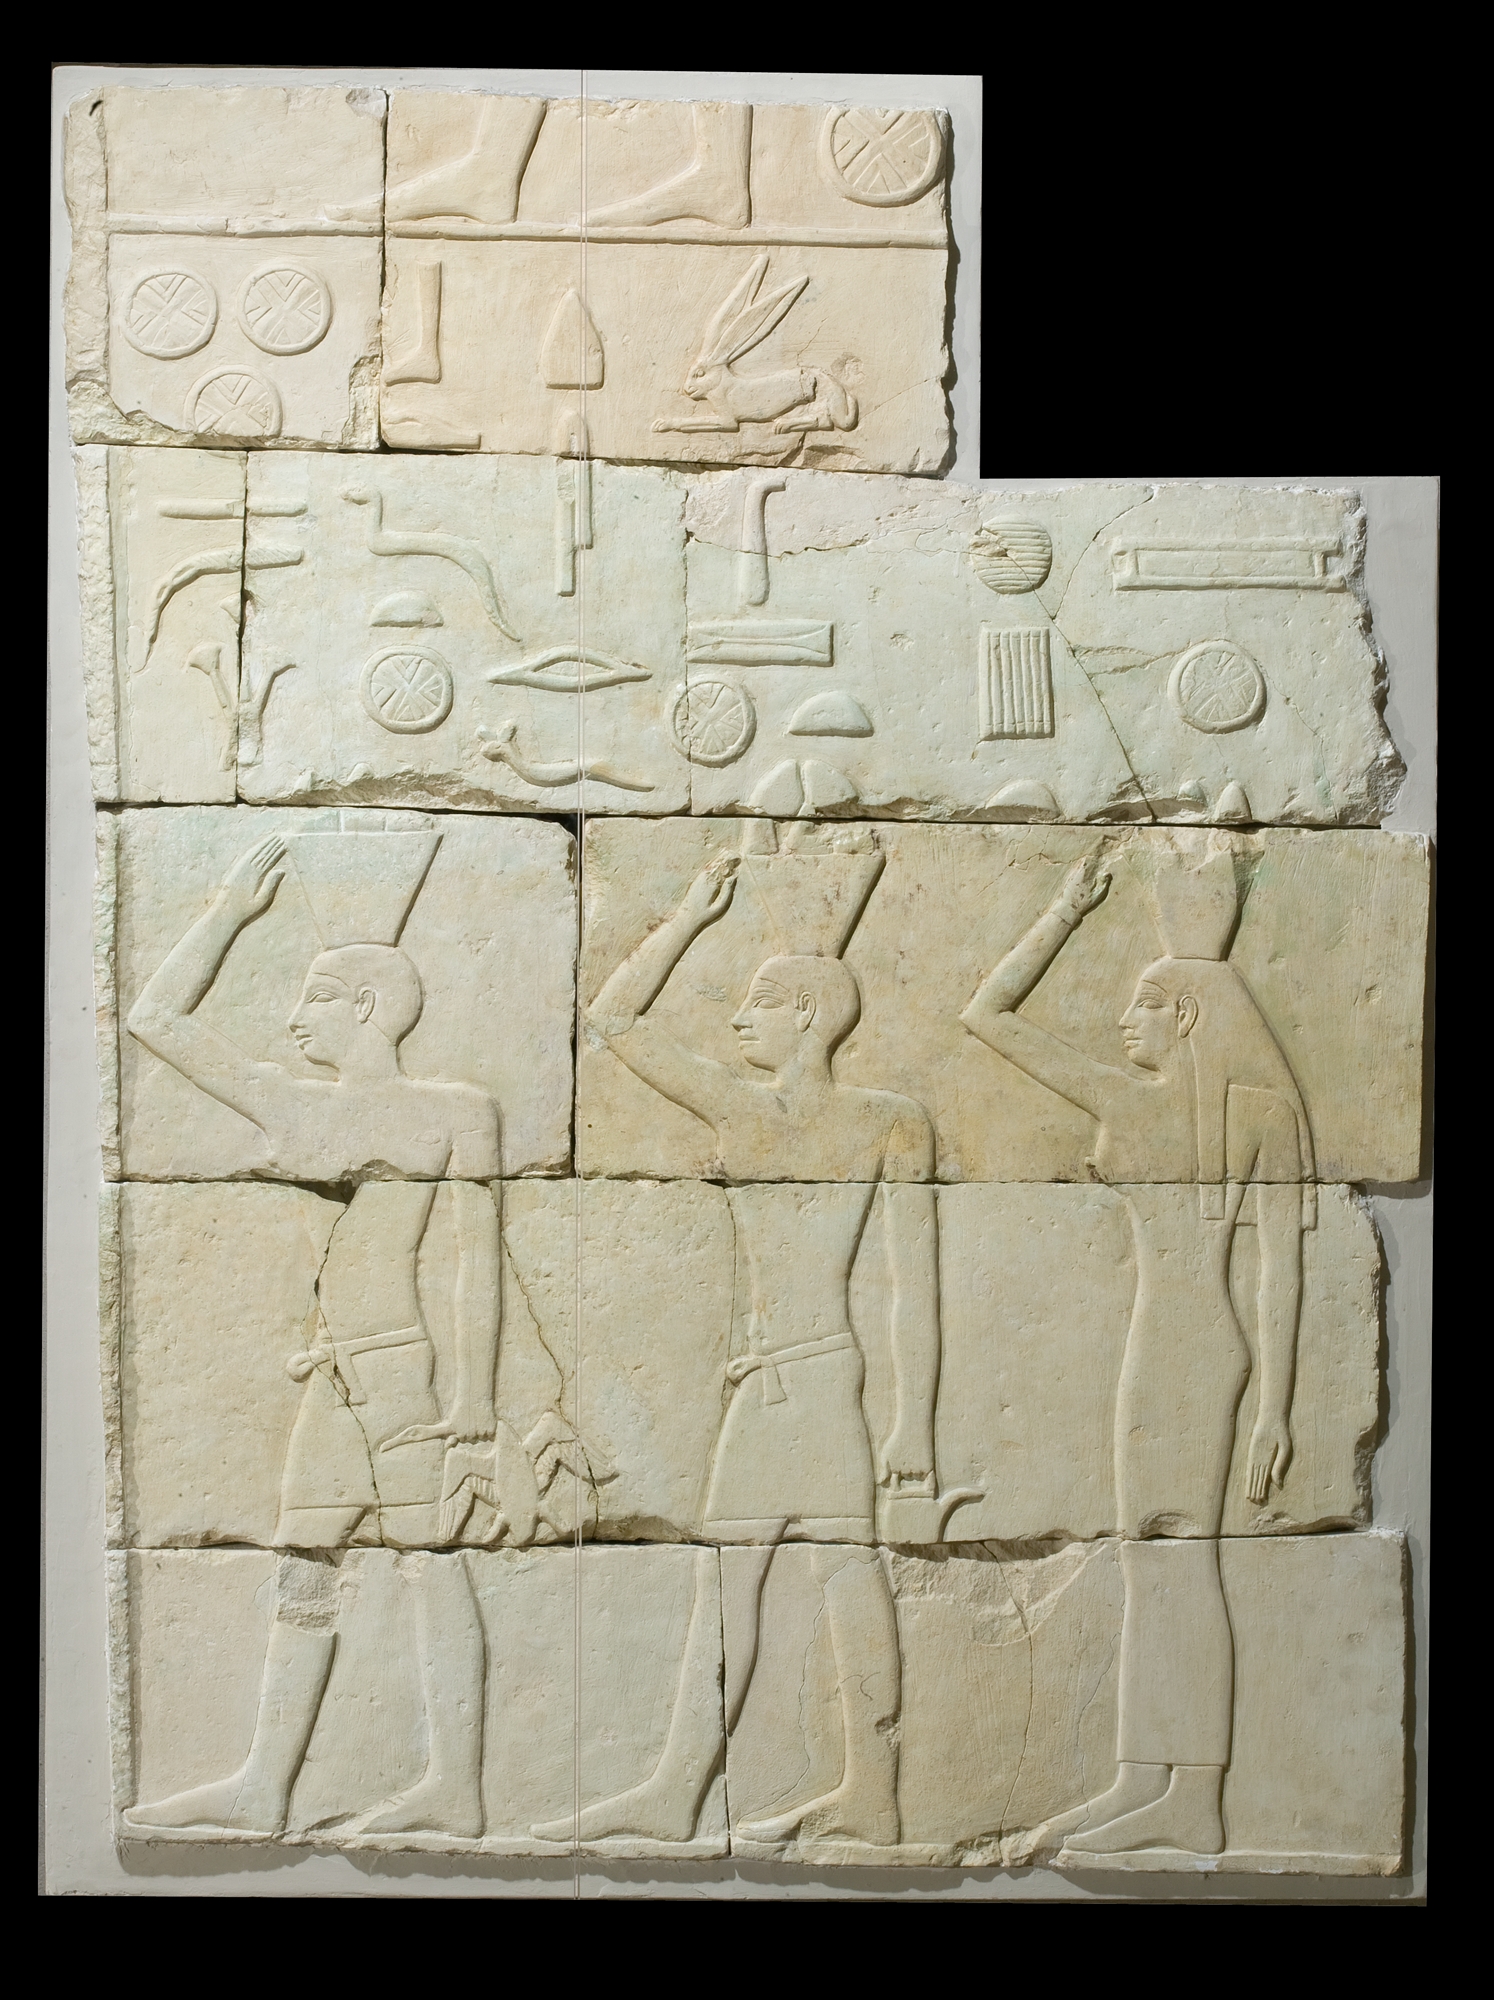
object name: relief, akhtihotep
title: Relief Depicting Personified Estates from the Tomb of Akhtihotep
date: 2575-2551 BCE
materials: limestone, paint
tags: men,women,hieroglyphs